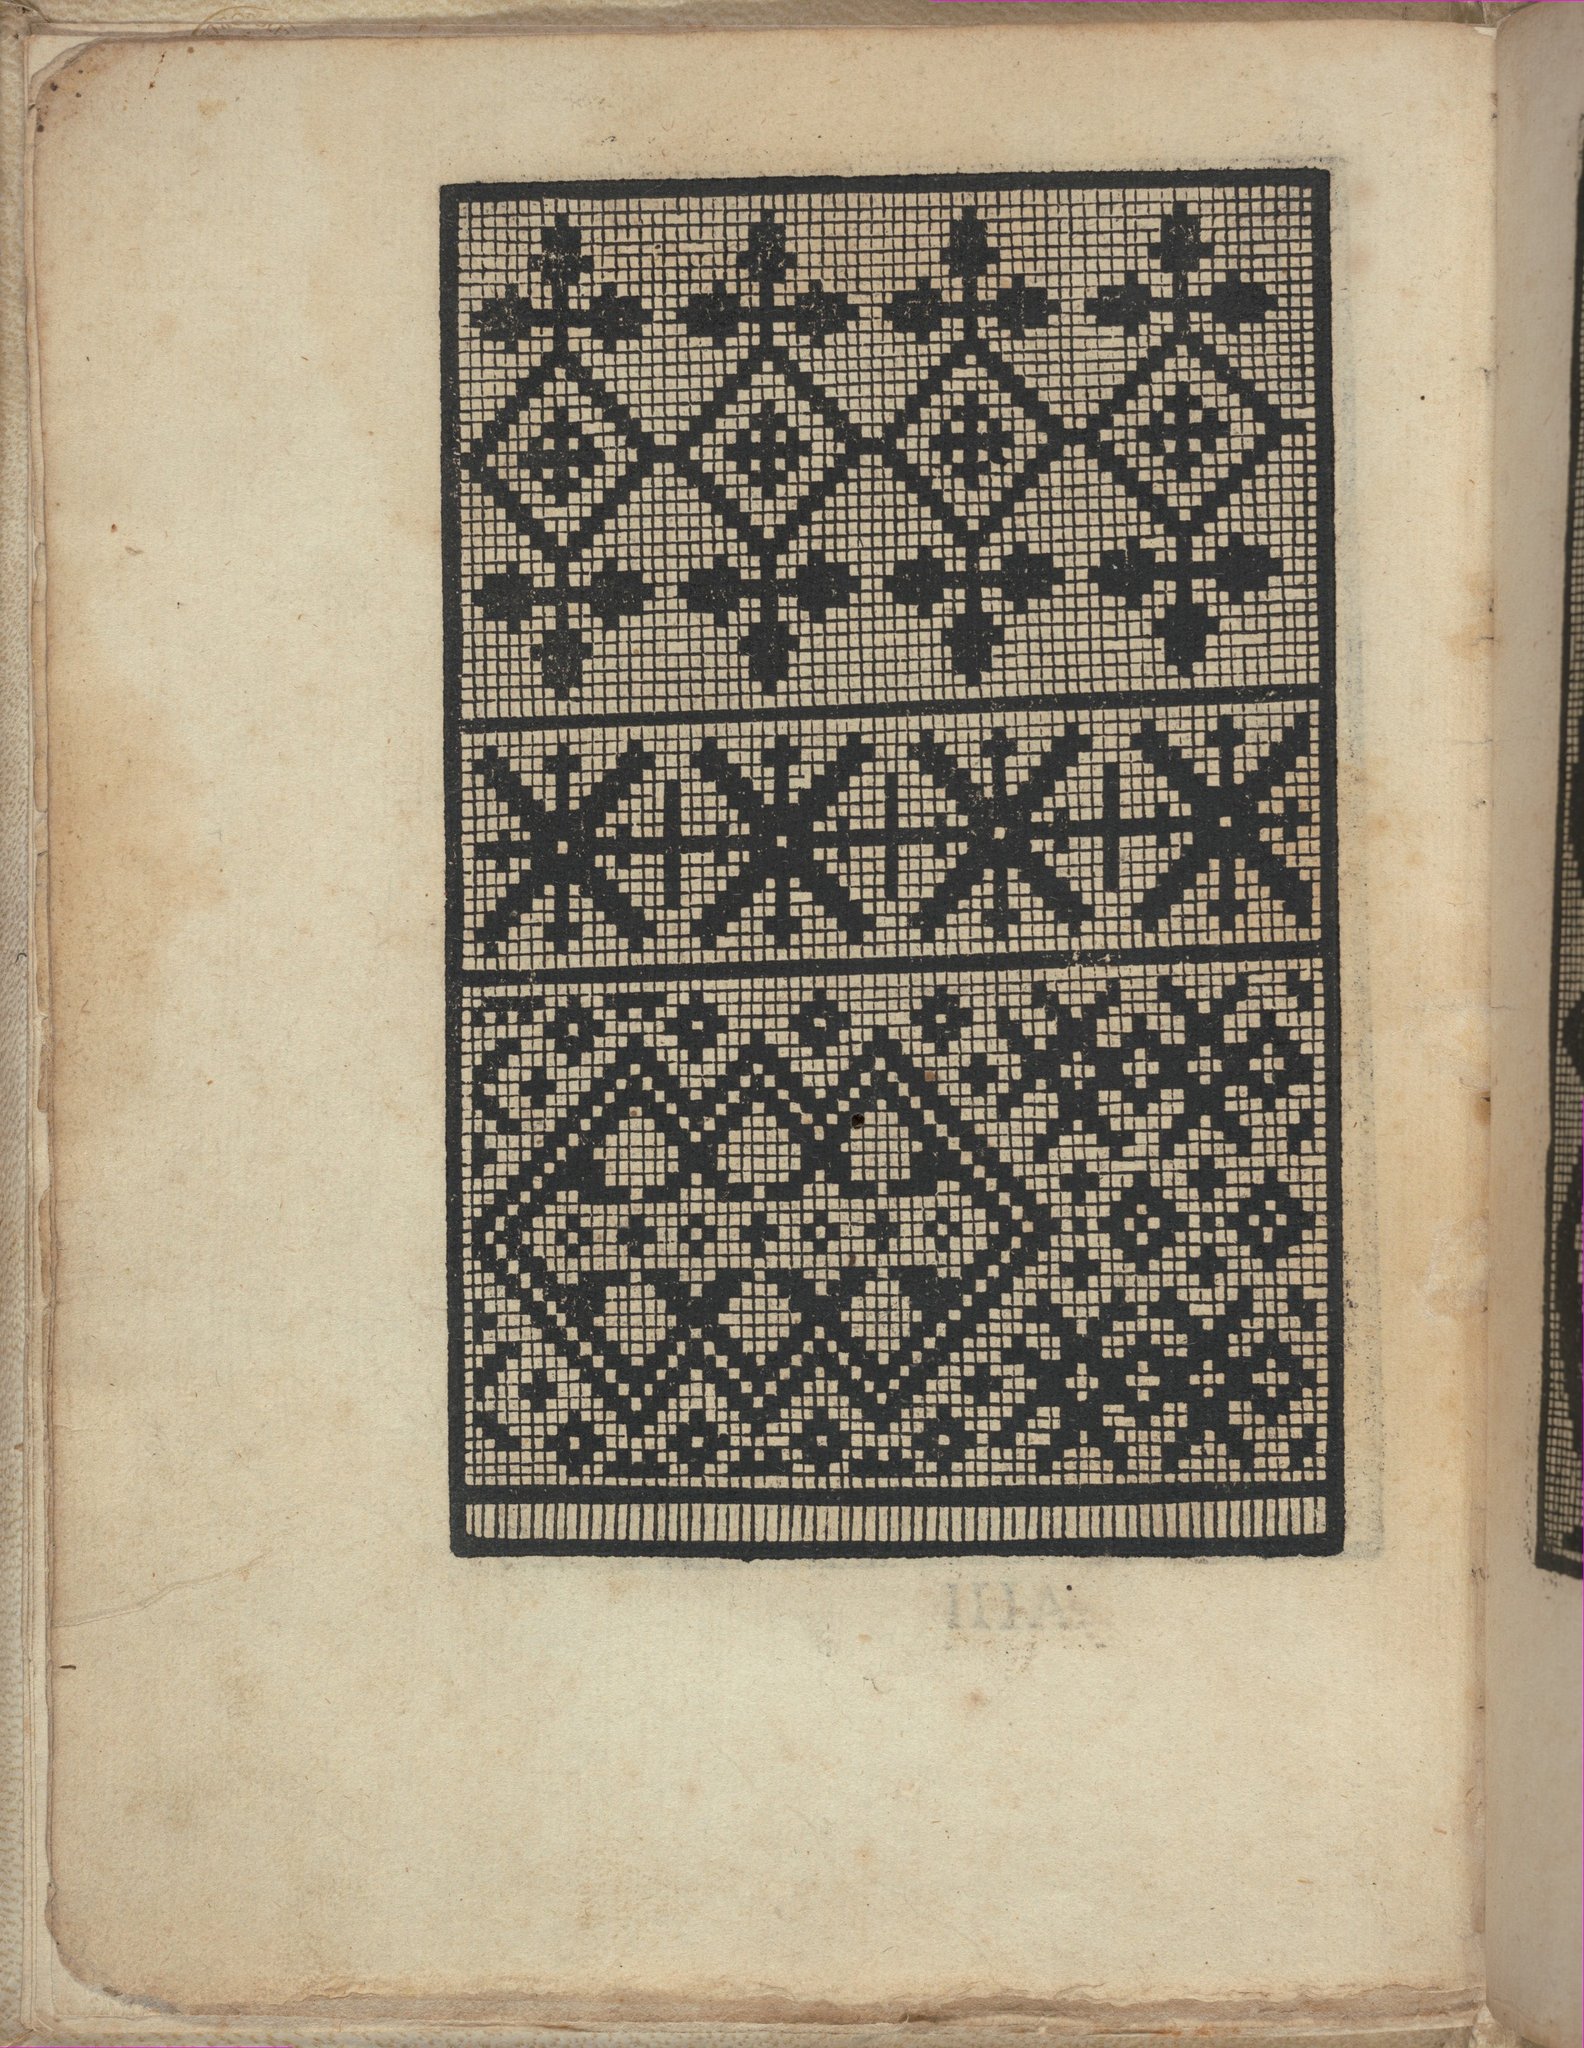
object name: book print ornament architecture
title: Esemplario di Lauori..., page 3 (recto)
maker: giovanni andrea vavassore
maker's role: publisher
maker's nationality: italian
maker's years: 1530-1573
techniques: woodcut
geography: venice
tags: ornament